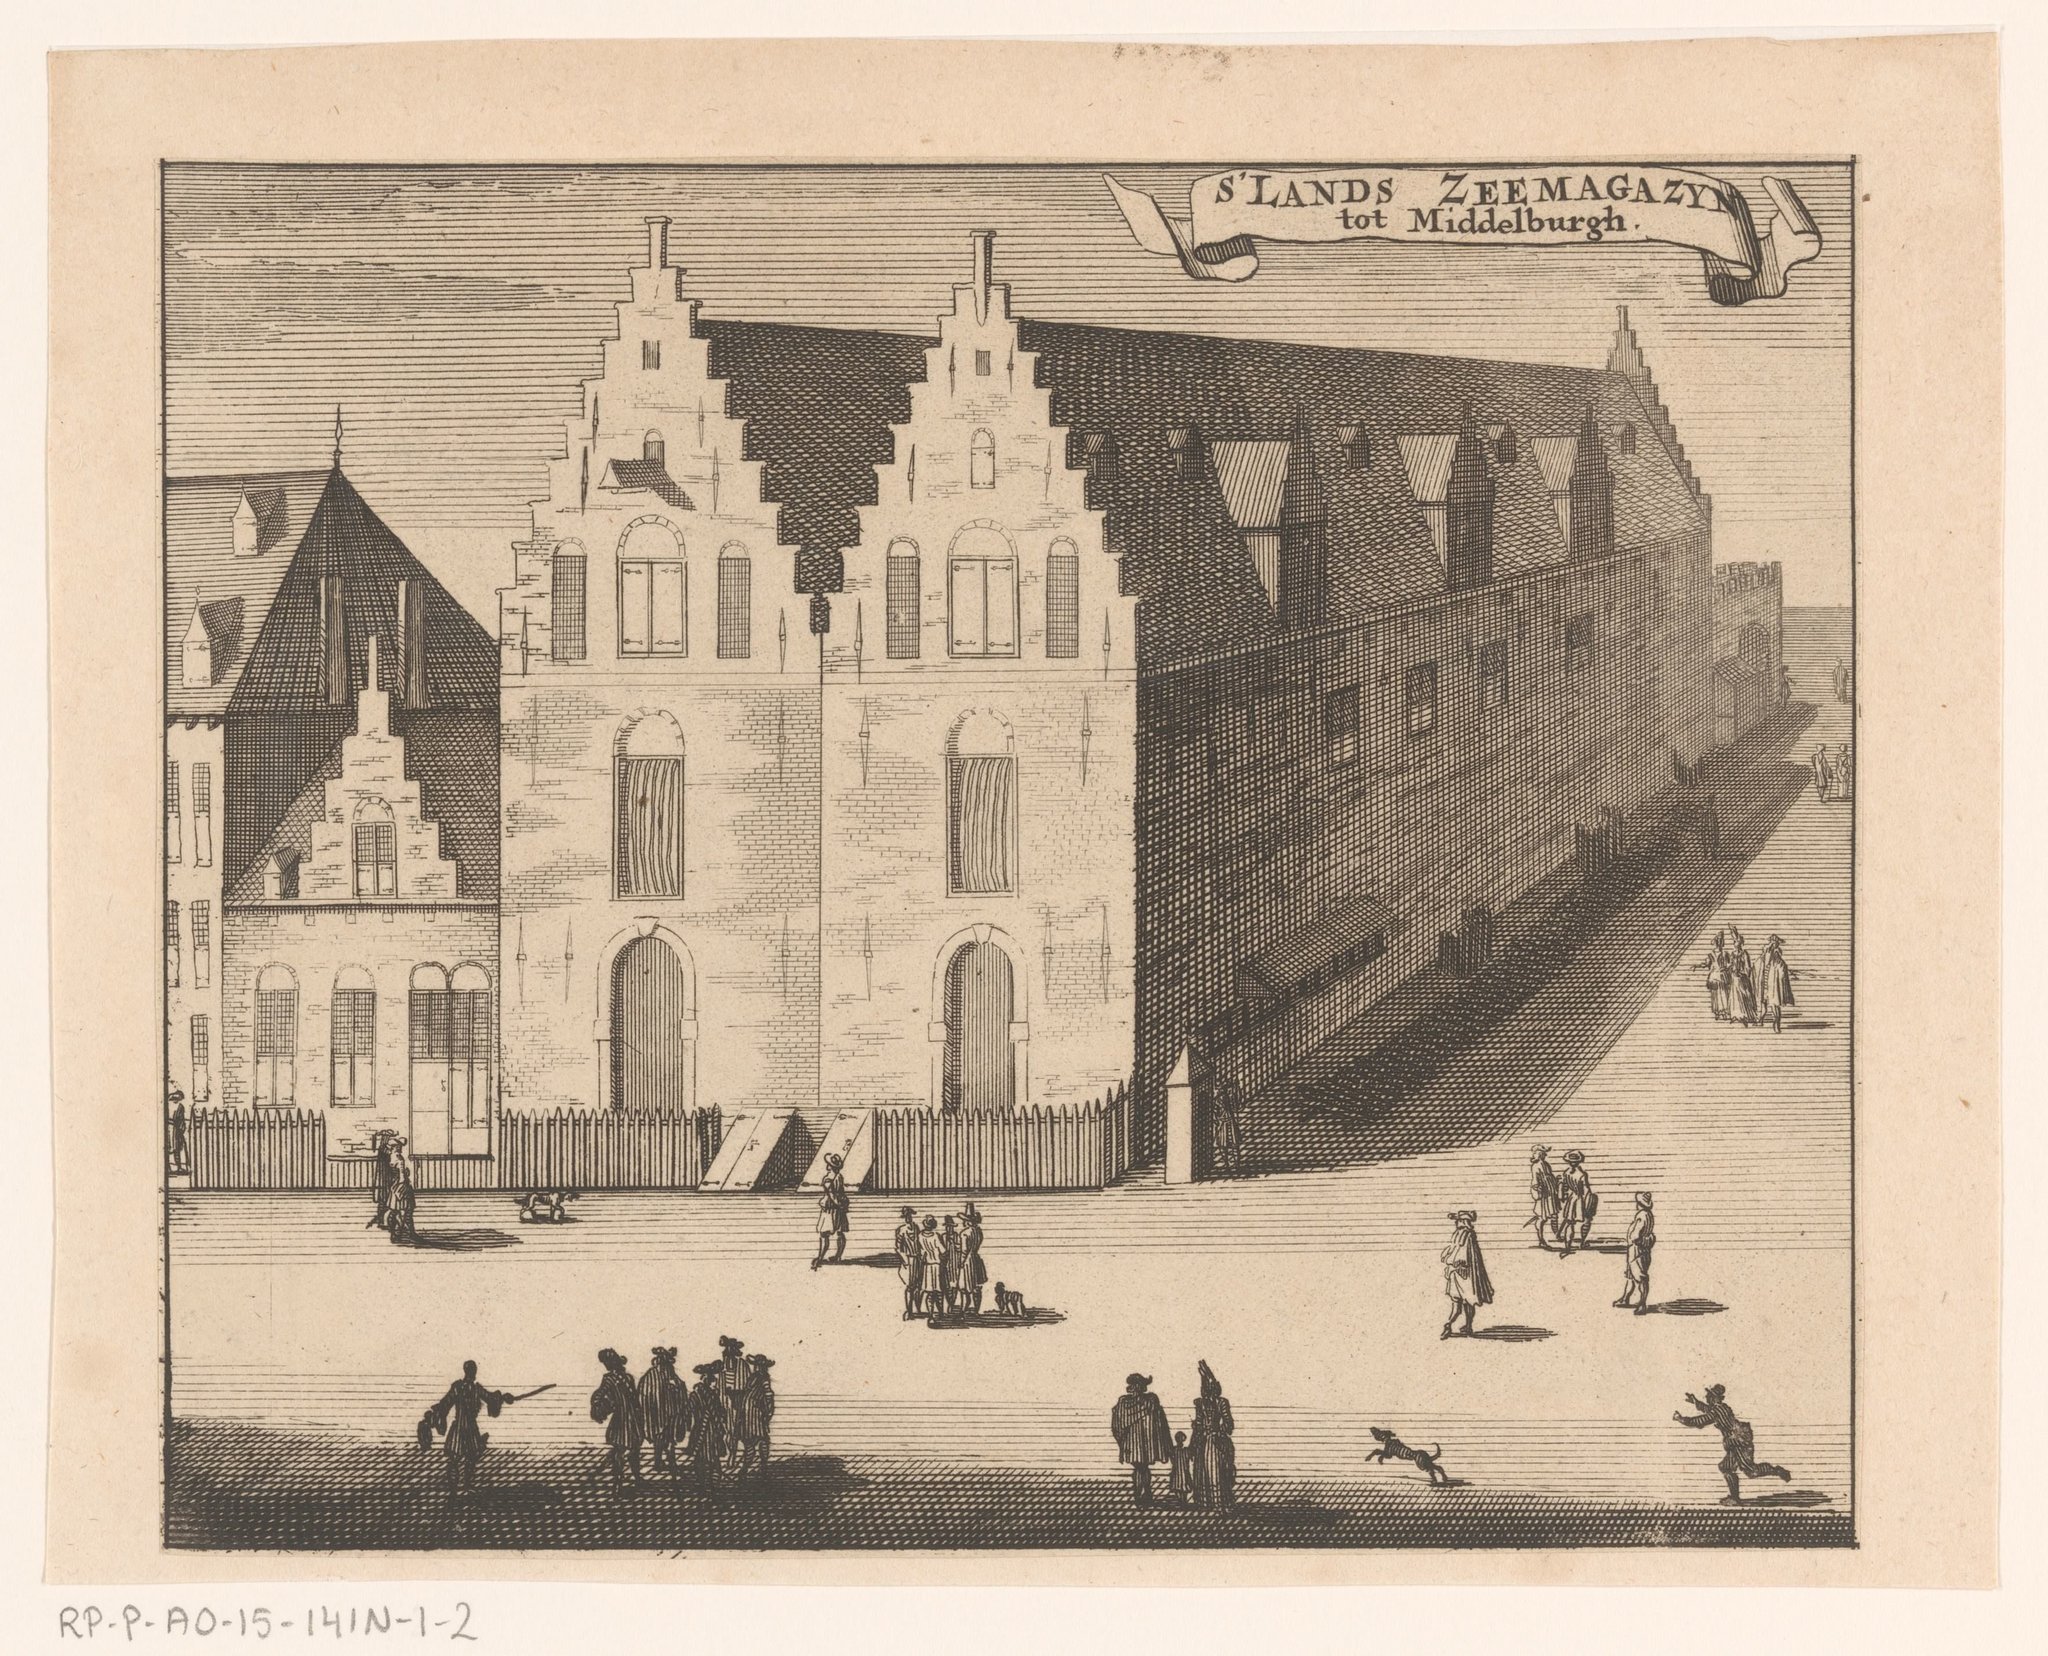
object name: book illustration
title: 's Lands Zeemagazijn Middelburg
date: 1696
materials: paper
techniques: engraving, etching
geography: amsterdam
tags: large-scale structure for storage, e.g.: warehouse, depot, silo, street (+ city(-scape) with figures, staffage)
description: Oorspronkelijk van één plaat gedrukt met drie andere voorstellingen (zie RP-P-AO-15-141K-1-2, RP-P-AO-15-141L2-2 en RP-P-AO-15-141M-2-2). Prent in zijn geheel ook gebruikt in: Smallegange, Mattheus. Nieuwe Cronyk van Zeeland (…). Middelburg en Amsterdam: Johannes Meertens en Abraham van Someren, 1696. Huidige voorstelling later (plaat mogelijk versneden) met andere voorstelling van zelfde plaat en apart gedrukte sierrand ook gebruikt in: Aa, Pieter van der. La galerie agreable du monde (...). 66 delen. Leiden: Pieter van der Aa, 1728, dl. 20.